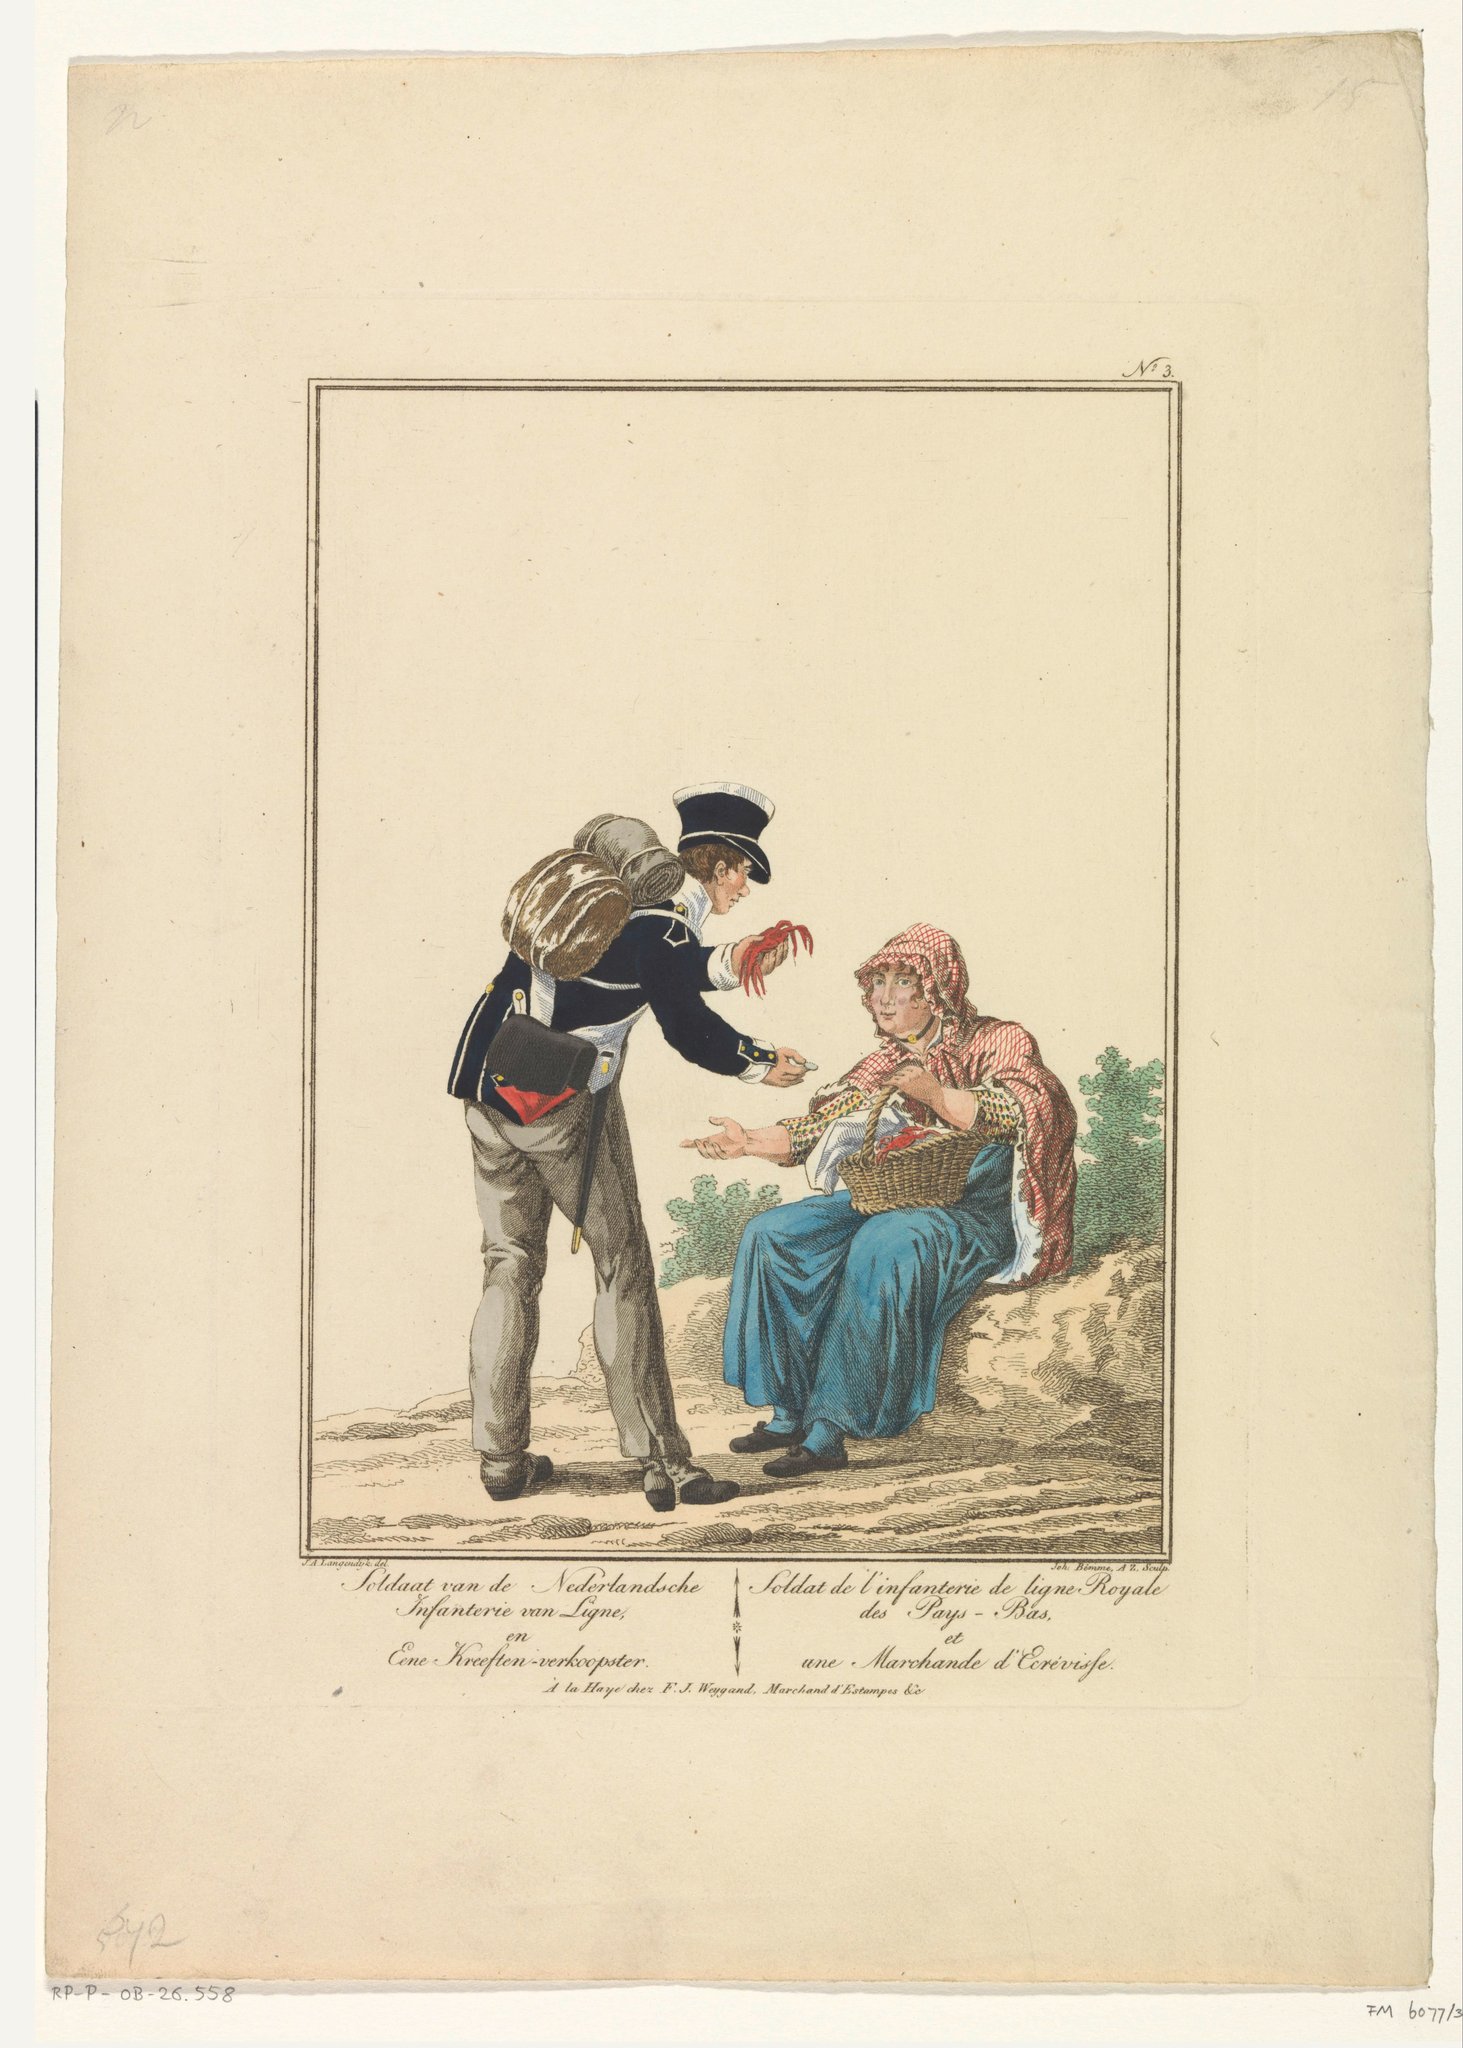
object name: print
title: Staande soldaat met kreeftenverkoopster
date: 1800-1841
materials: paper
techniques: etching, hand coloring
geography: rotterdam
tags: street-trader - bb - women engaged in trade and commerce, folk costume, regional costume, (military) uniforms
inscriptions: collector's mark: Lugt 2228